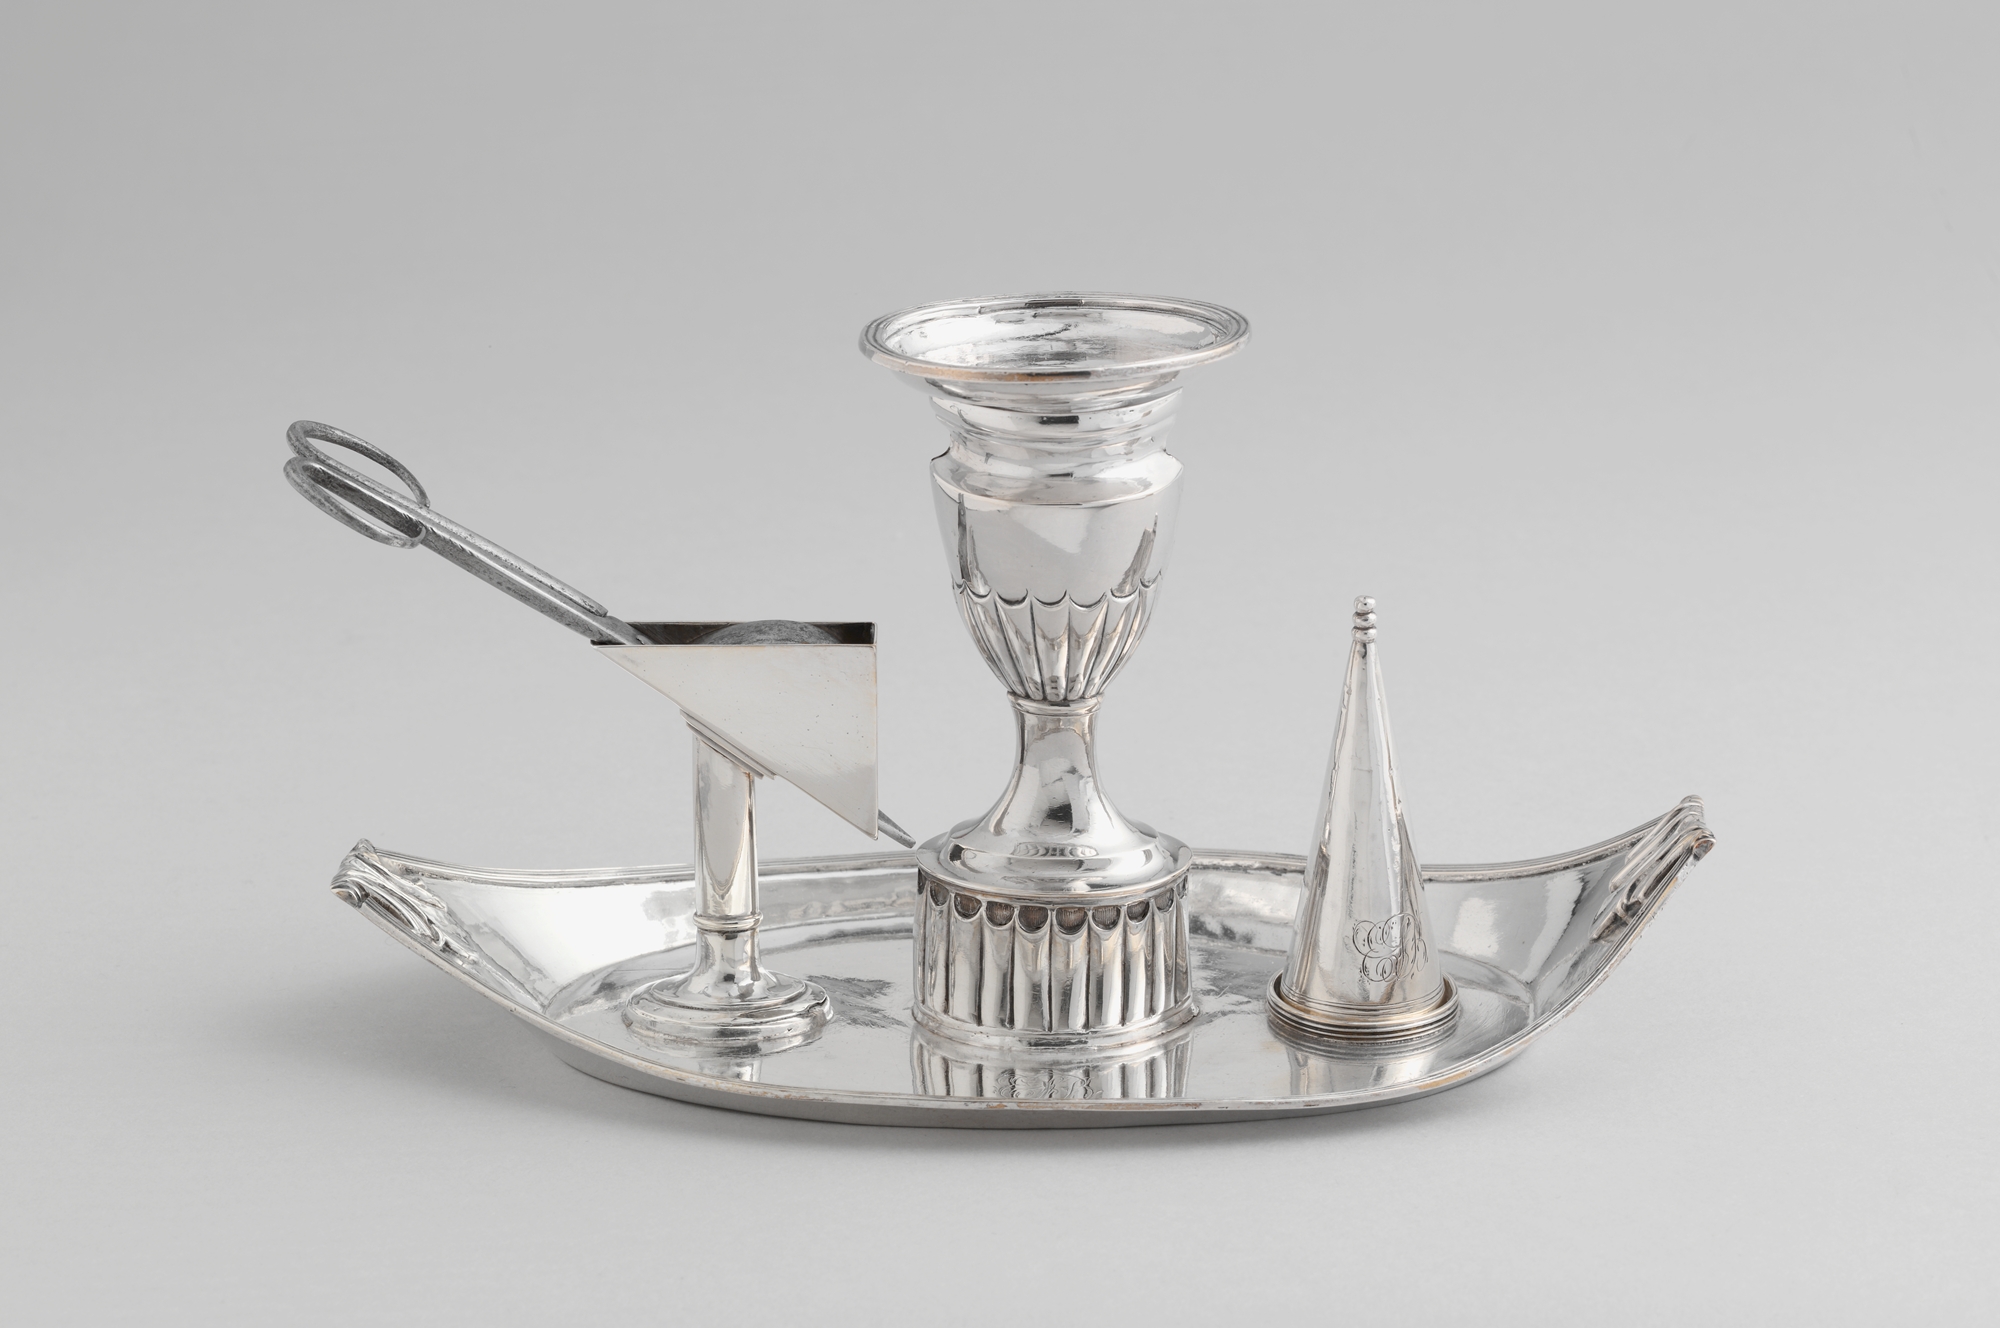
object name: candlestick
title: Candle Holder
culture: american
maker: joseph lownes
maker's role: maker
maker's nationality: american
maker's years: 1758-1820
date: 1790-1810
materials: silver, steel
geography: united states